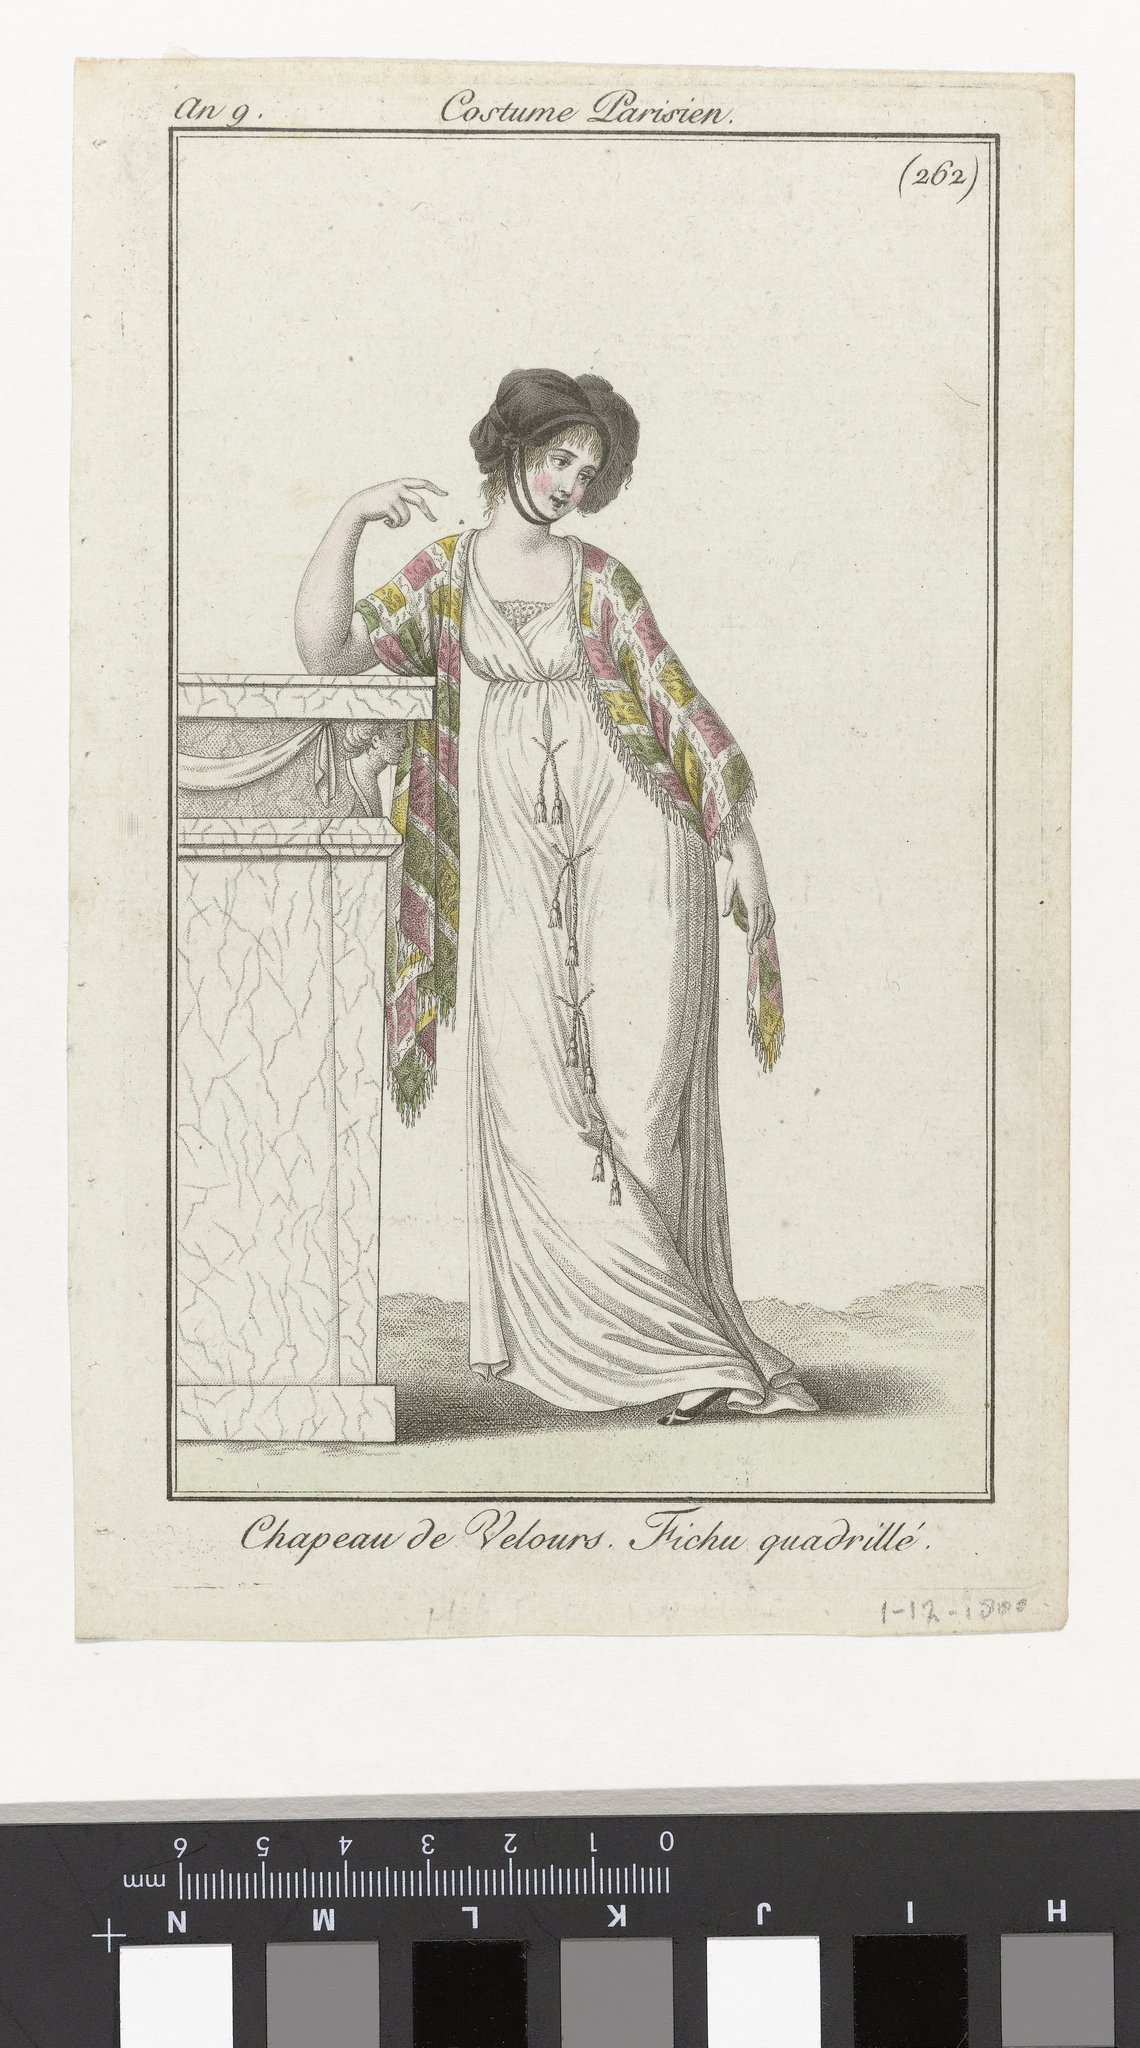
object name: fashion print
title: Journal des Dames et des Modes, Costume Parisien, 1 décembre 1800, An 9, (262) : Chapeau de Velours (...)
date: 1800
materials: paper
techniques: engraving, hand coloring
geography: paris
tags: clothing for the upper part of the body (+ women's clothes), head-gear (+ women's clothes), fashion plates, shoes, sandals (+ women's clothes), dress, gown (+ women's clothes)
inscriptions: caption: ‘Chapeau de Velours. Fichu quadrillé.’, title: ‘Costume Parisien.’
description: Staande vrouw, leunend tegen een sokkel, met op het hoofd een hoed van fluweel met struisveer. Om de schouders een geruite fichu, afgezet met franjes. Zij draagt een japon met overslag, gesloten met koorden met kwasten. platte schoen. De prent maakt deel uit van het modetijdschrift Journal des Dames et des Modes, uitgegeven door Pierre de la Mésangère, Parijs, 1797-1839.